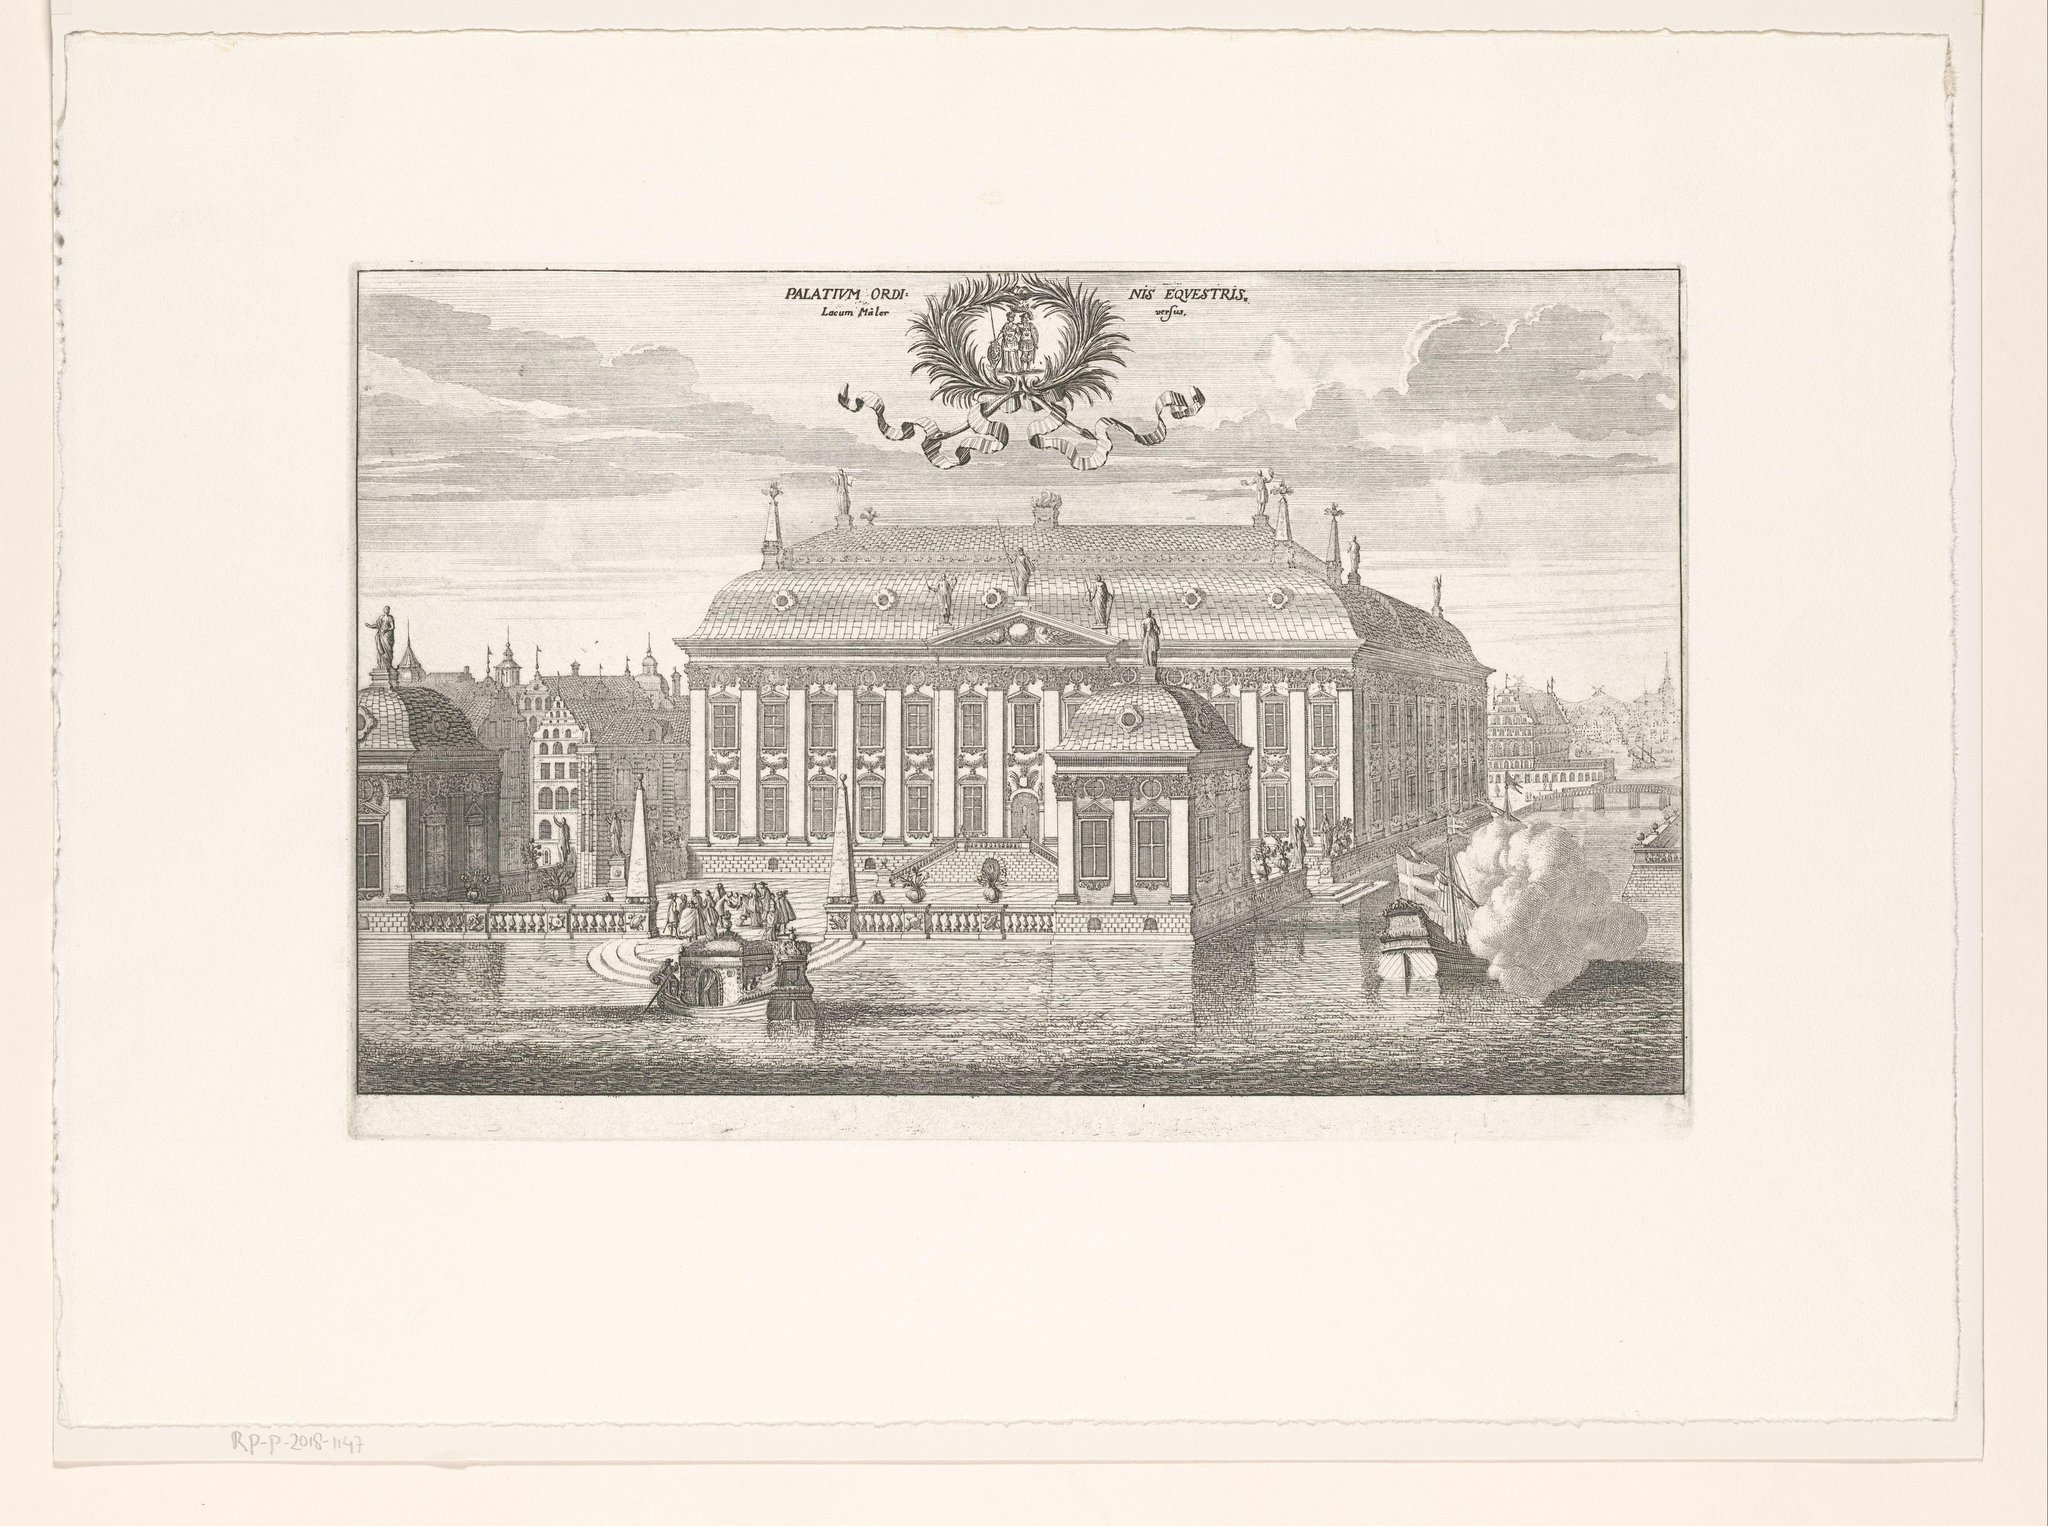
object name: print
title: Palatium ordinis equestris Lacum Mäler versus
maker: Anonymous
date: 1699-1715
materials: paper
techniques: etching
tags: palace, nobility and patriciate; chivalry, knighthood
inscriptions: collector's mark: ‘Nationalmuseum Nytryck’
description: Prent oorspronkelijk gebruikt in: Dahlberg, Erik Jonsson. Suecia Antiqua et Hodierna. 3 dln. Stockholm: s.n., 1699-1715.